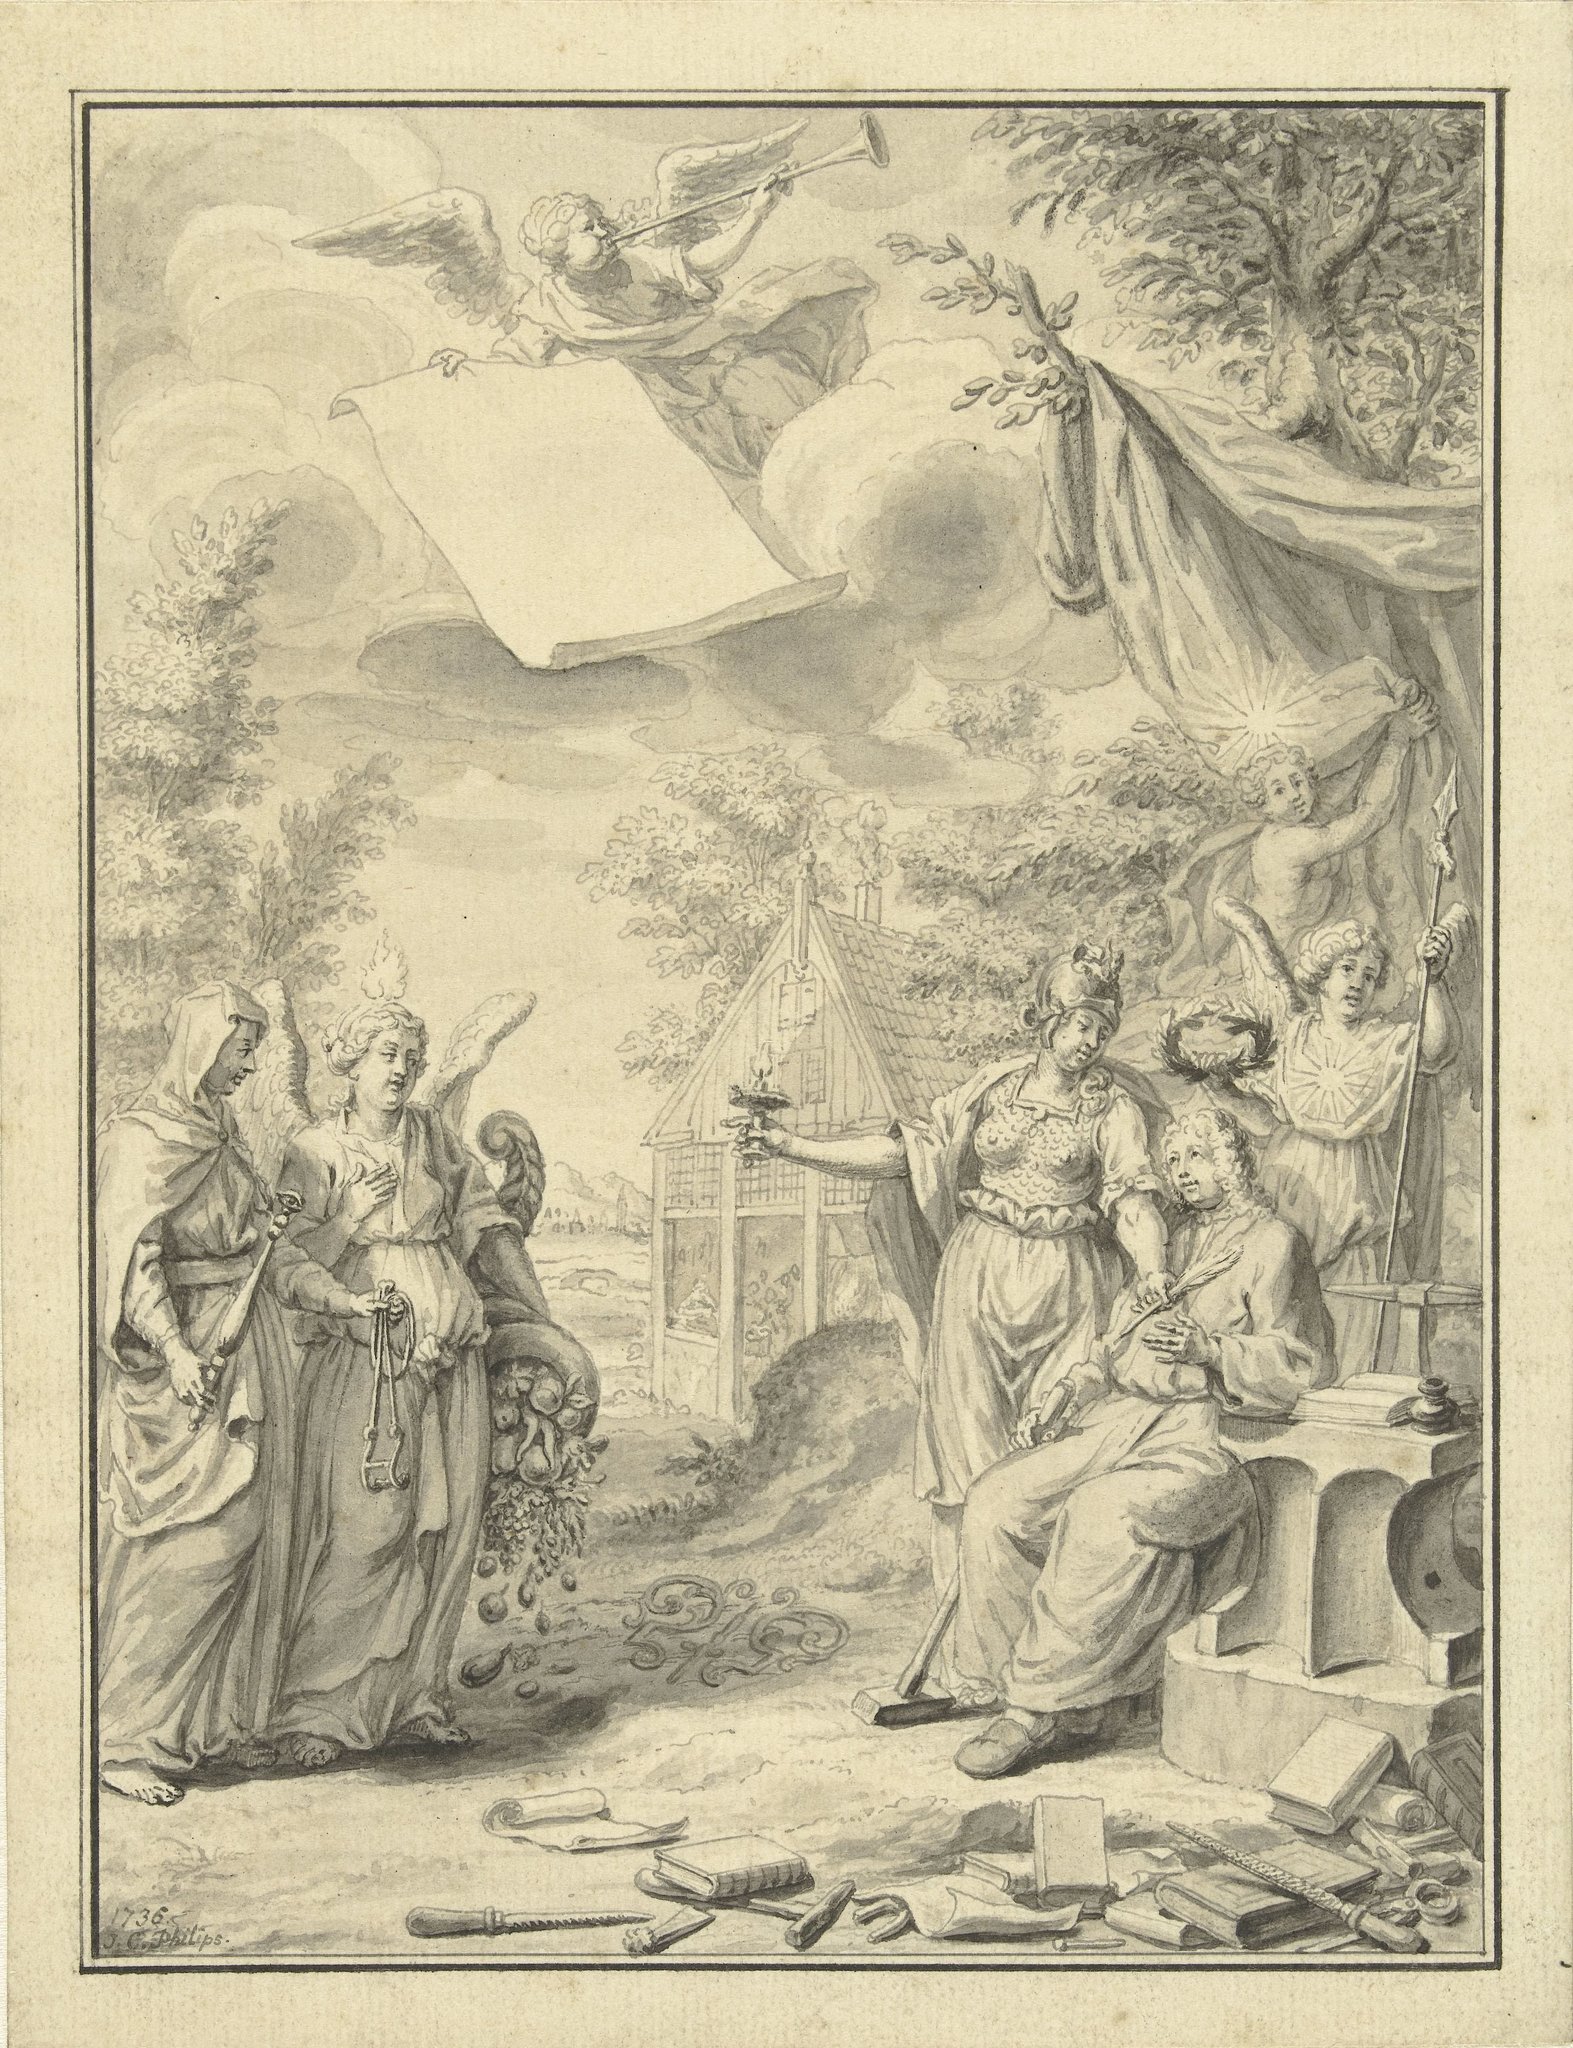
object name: drawing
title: Ontwerp voor titelpagina voor Alle de werken van Adriaan de Kramer, 1736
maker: jan caspar philips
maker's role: draughtsman, print maker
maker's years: 1700-1775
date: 1736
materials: ink, paper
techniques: brush, pen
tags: leiden, abundance; 'abondanza', 'abondanza maritima' (ripa), temperance, moderation; 'misura' (ripa)